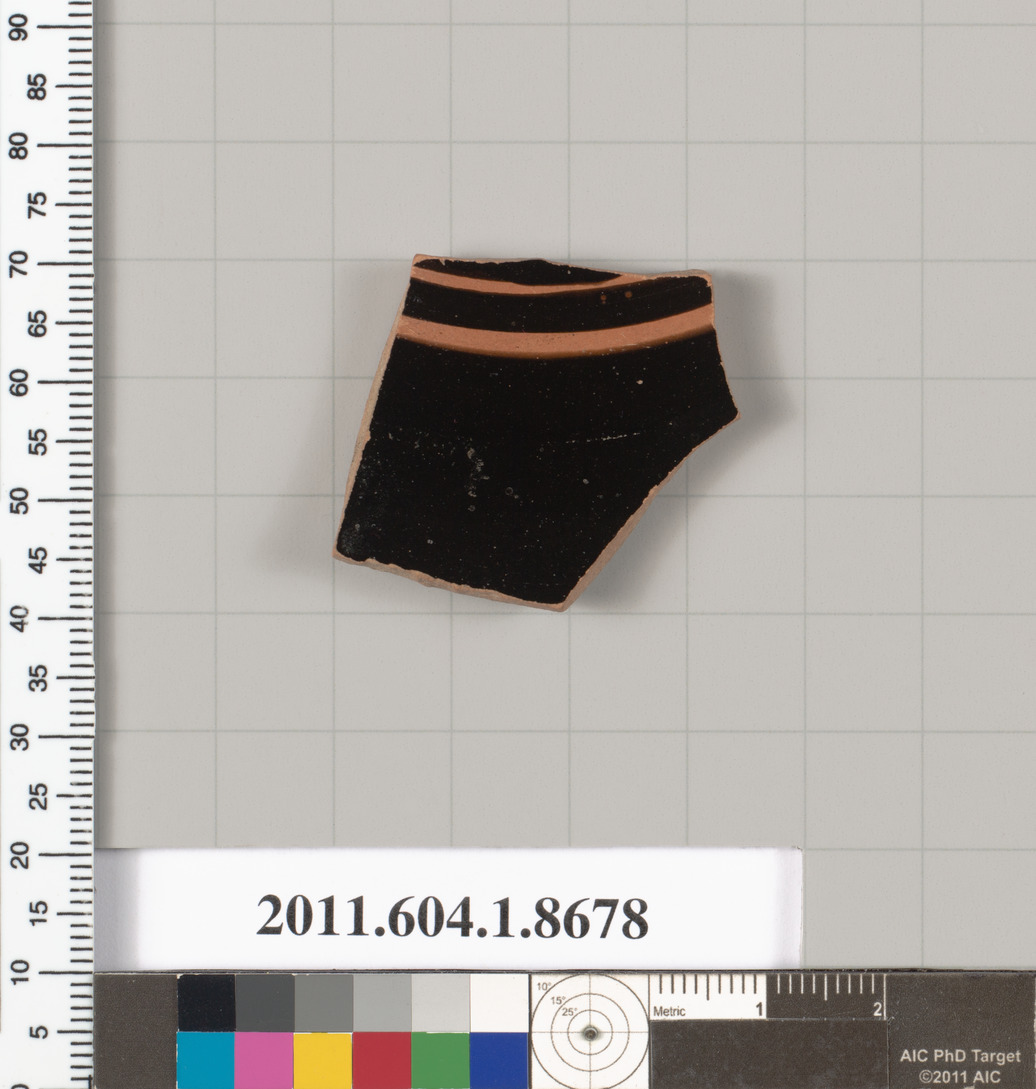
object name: kylix fragment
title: Terracotta fragment of a stemless kylix (drinking cup)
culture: greek, attic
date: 460-450 BCE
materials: terracotta